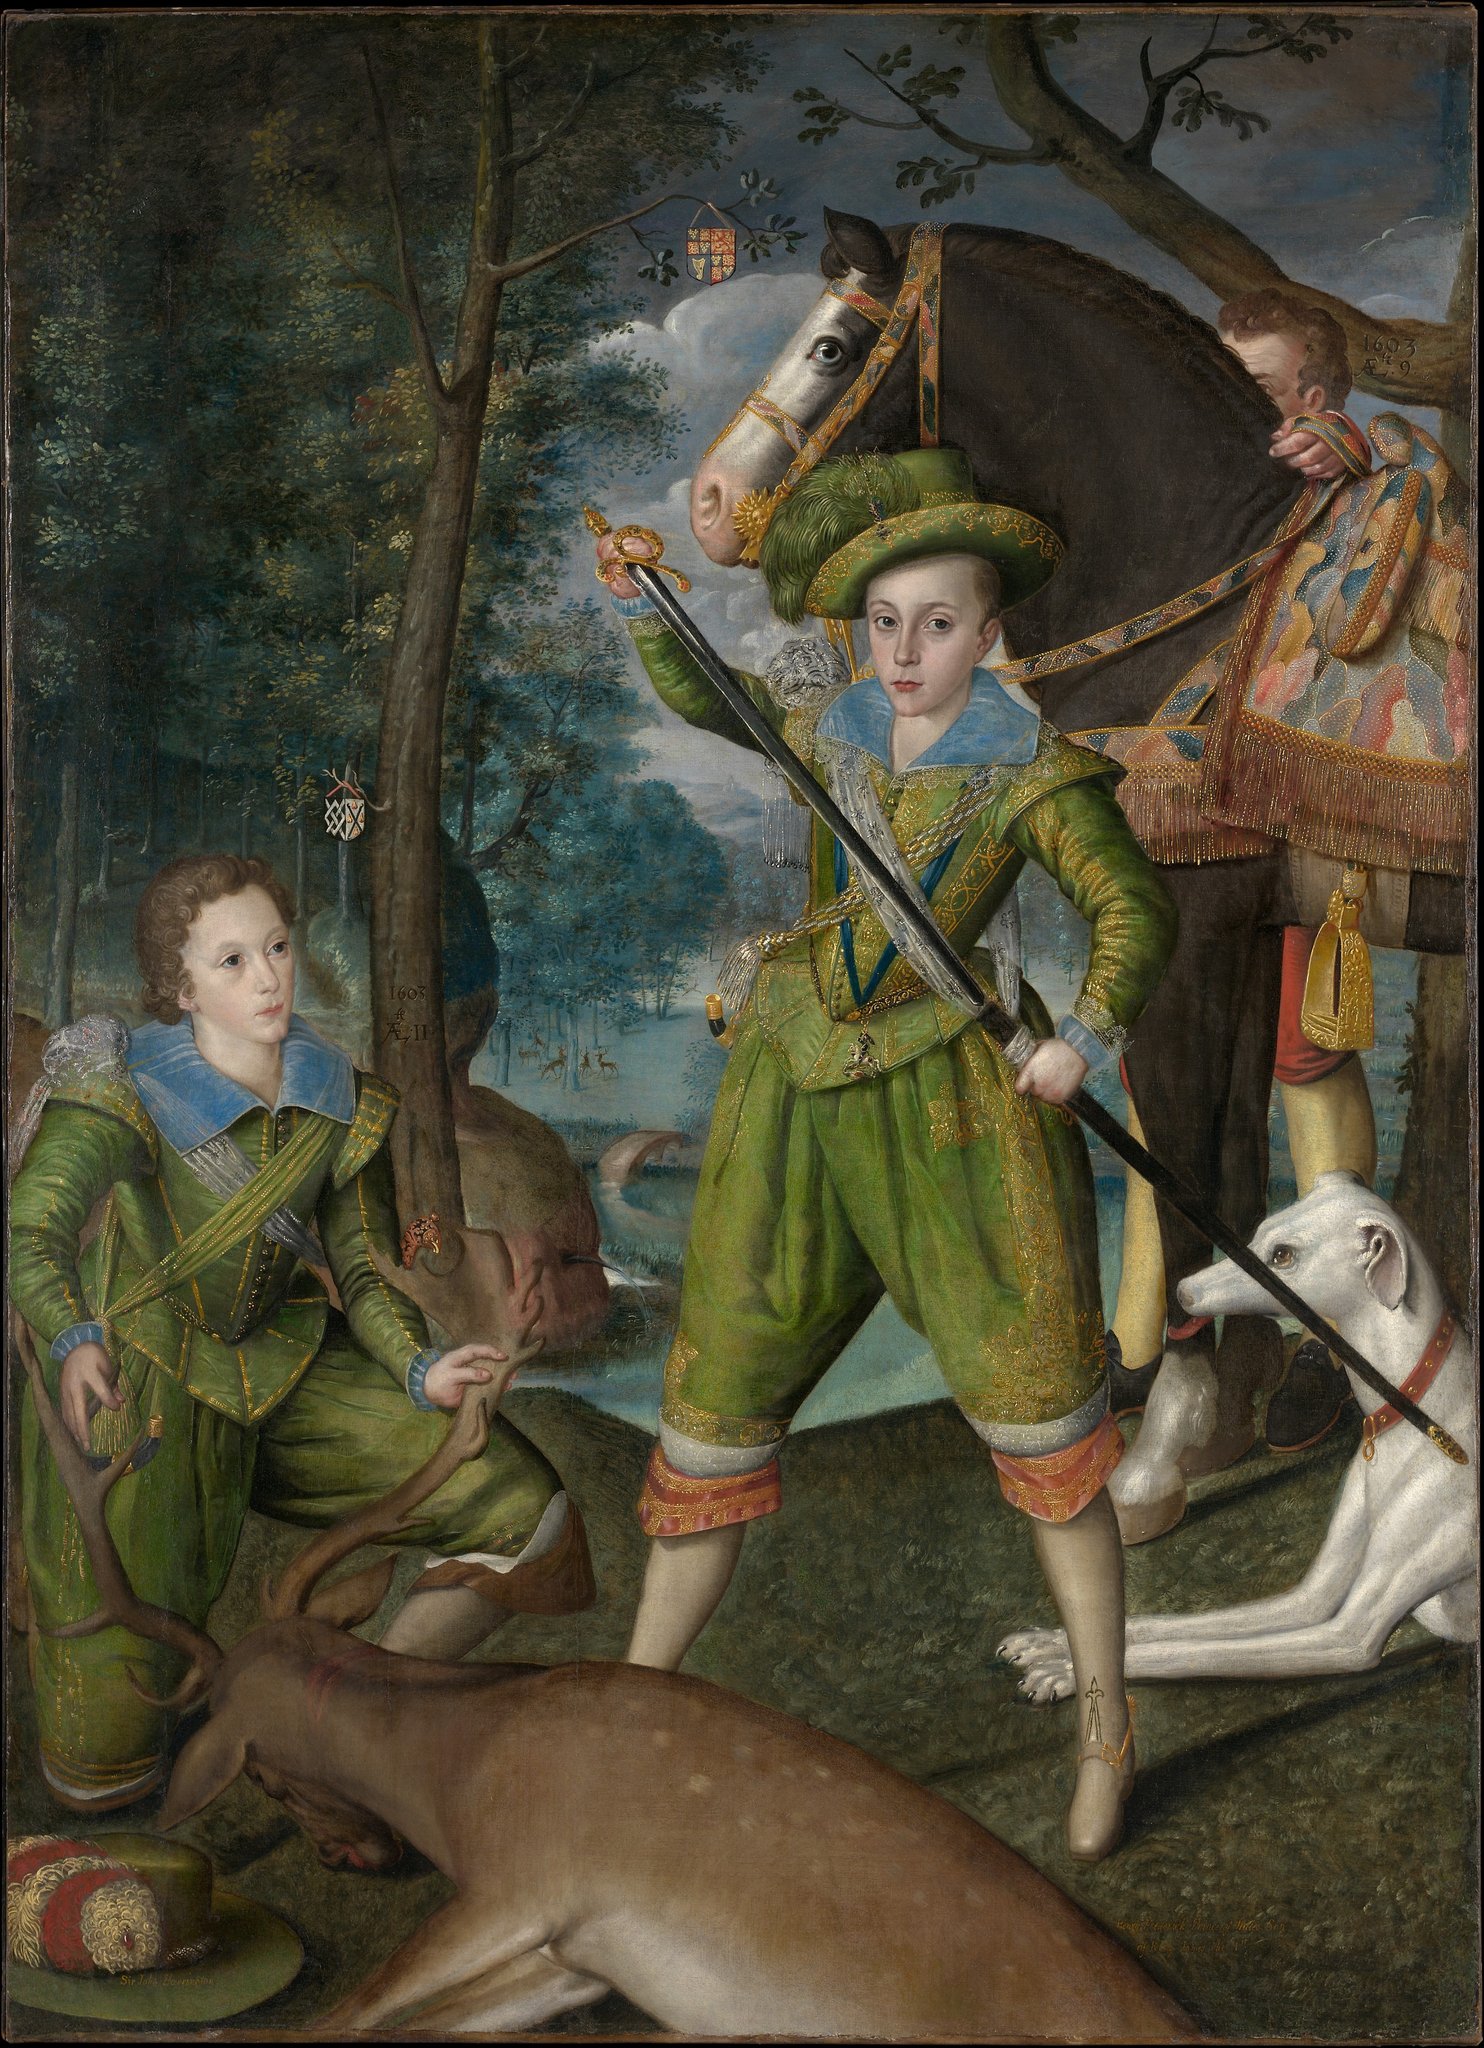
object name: painting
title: Henry Frederick (1594–1612), Prince of Wales, with Sir John Harington (1592–1614), in the Hunting Field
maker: robert peake the elder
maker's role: artist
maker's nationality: british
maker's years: 1546-1619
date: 1603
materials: canvas, oil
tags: princes,men,hunting,deer,dogs,horses